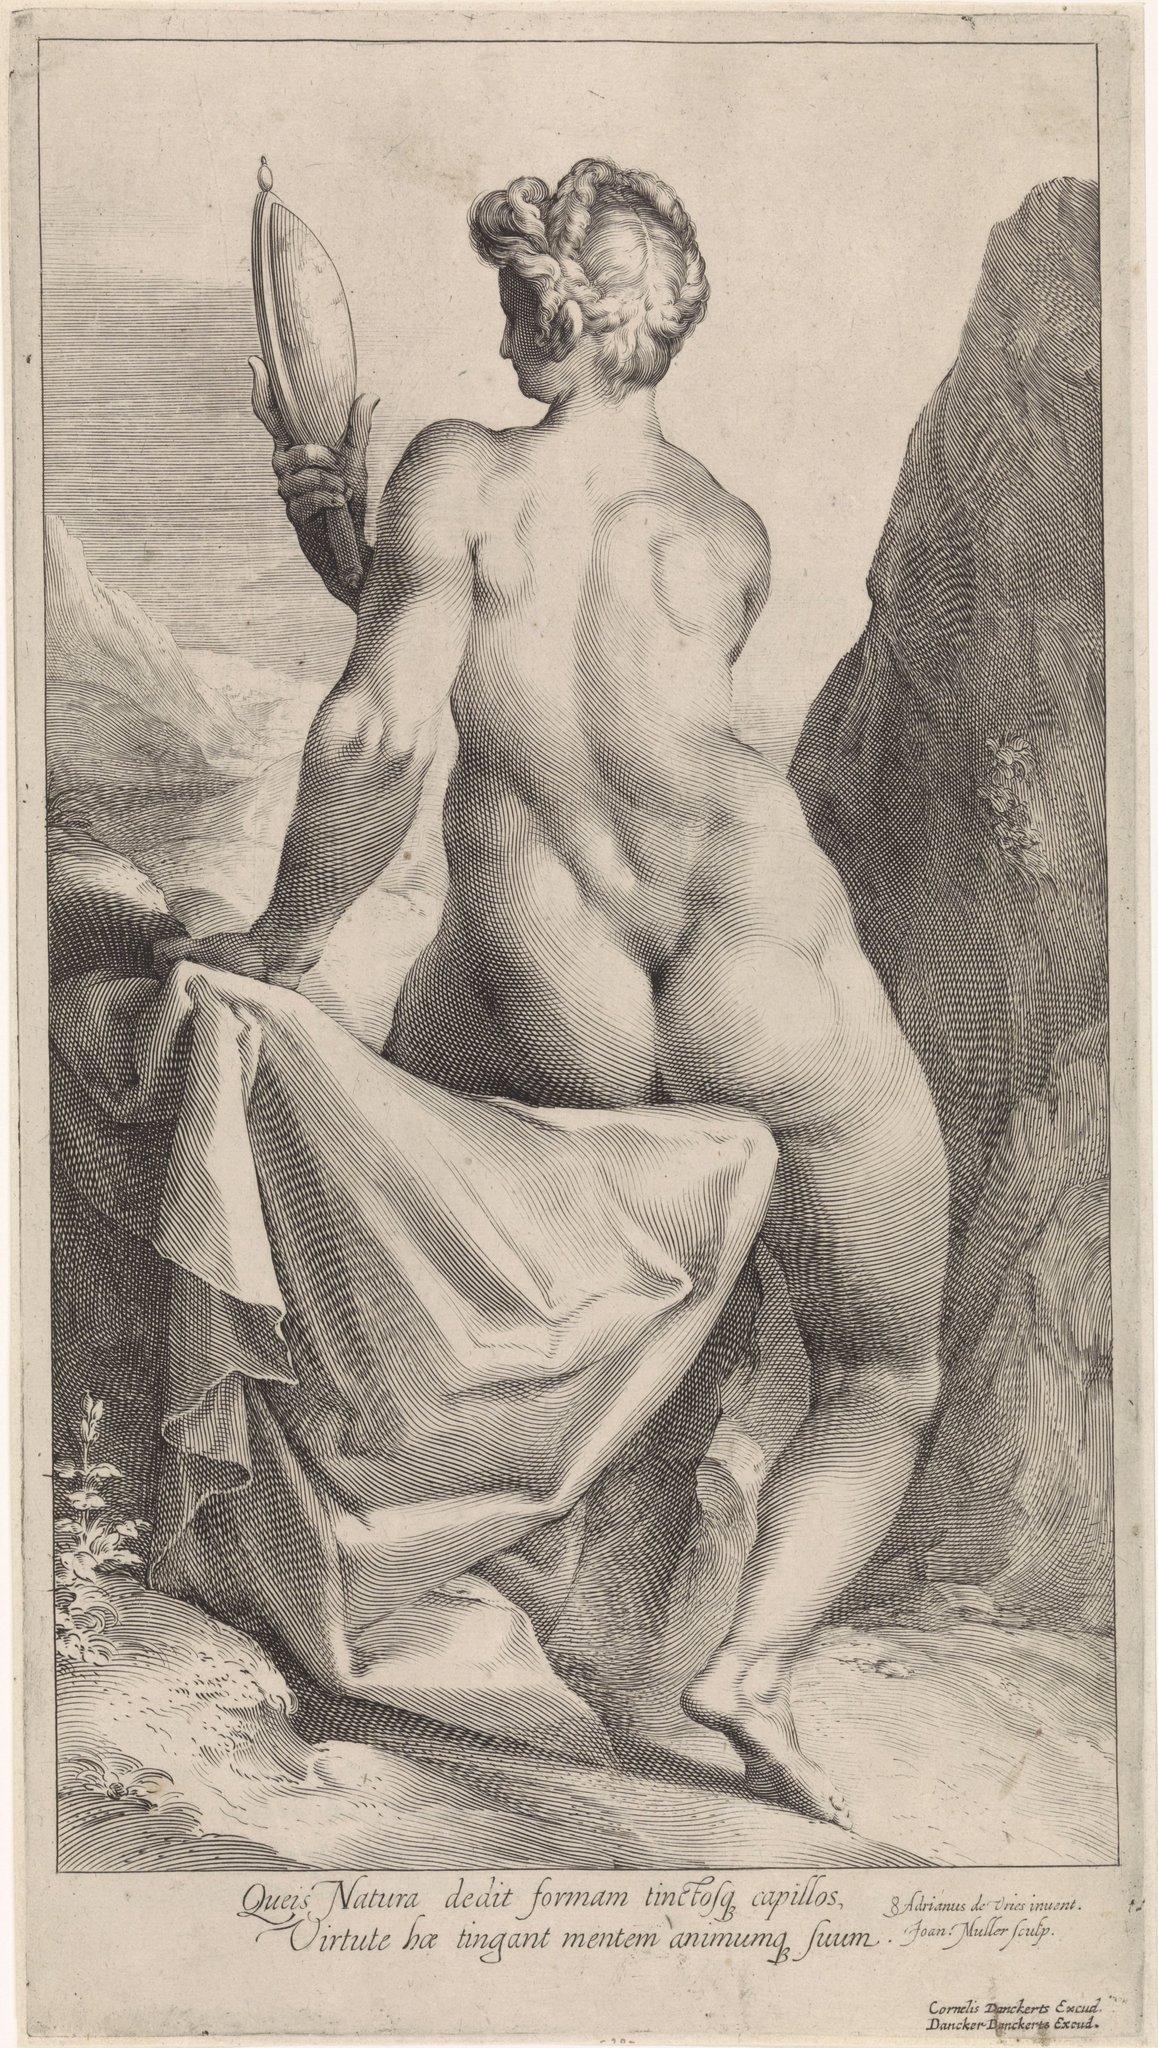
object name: print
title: Voorzichtigheid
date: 1654-1666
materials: paper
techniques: engraving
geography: amsterdam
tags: prudence, 'prudentia'; 'prudenza' (ripa) ~ one of the four cardinal virtues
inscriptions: collector's mark: Lugt 2228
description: Prudentia (voorzichtigheid) als naakte vrouw, zittend, op de rug gezien, kijkend in een spiegel.